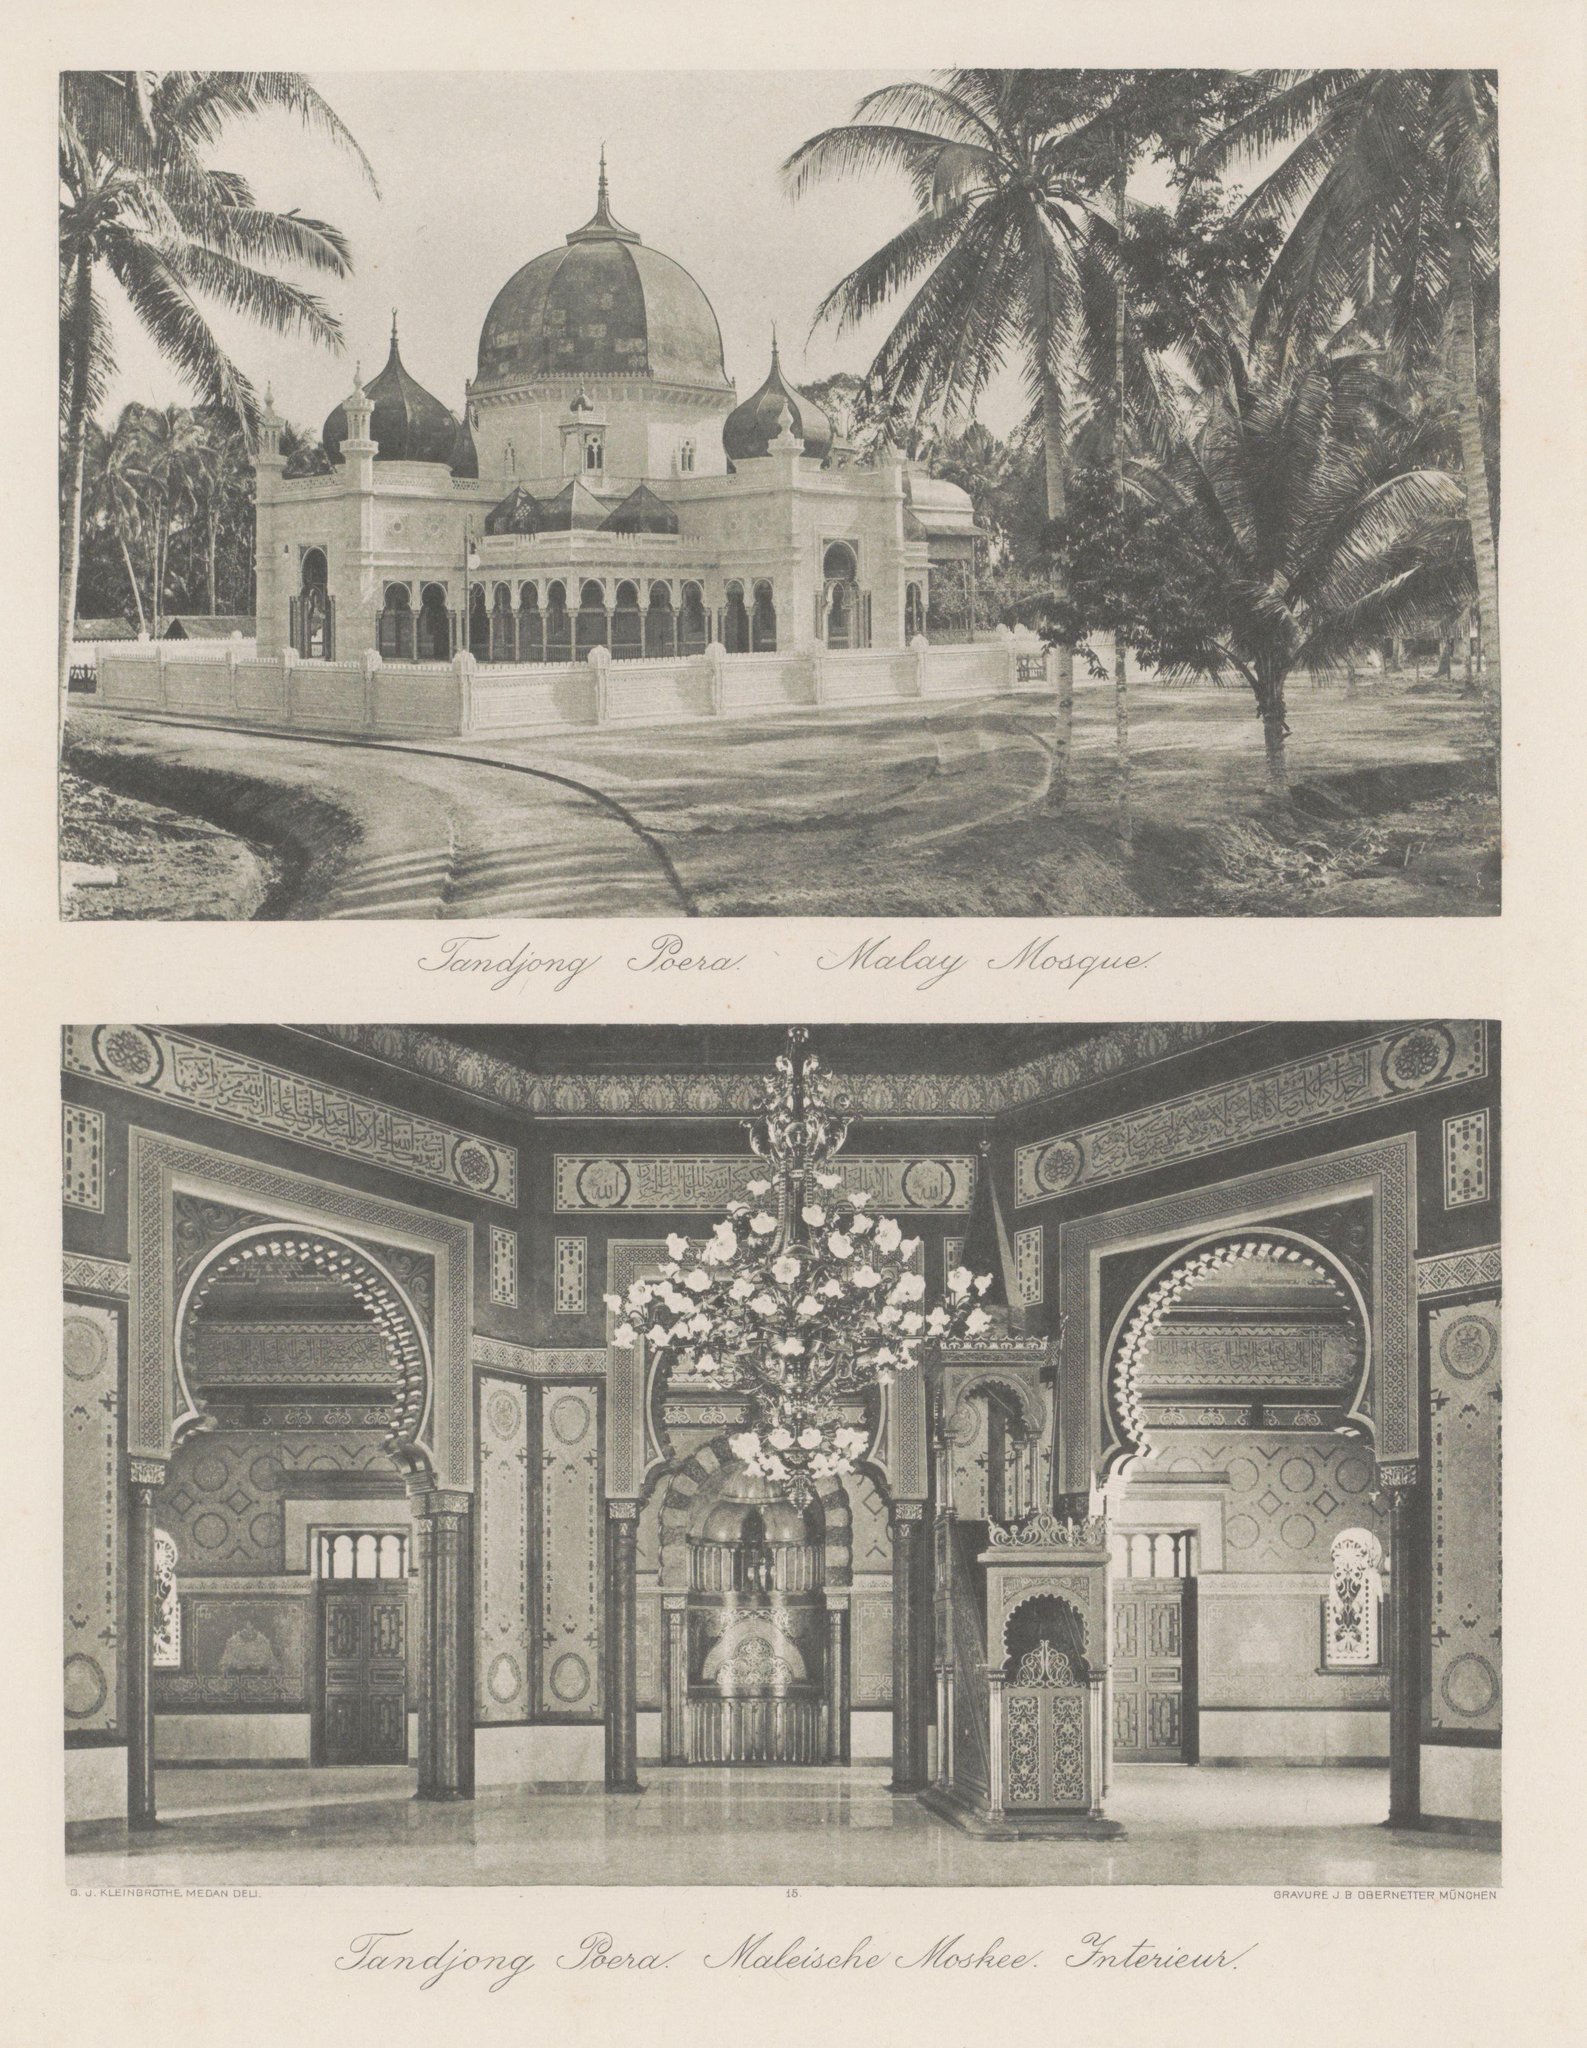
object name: photomechanical print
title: Exterieur (boven) en interieur (onder) van een Maleise moskee in Tanjungpura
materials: paper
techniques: photoaquatint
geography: munich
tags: temple, shrine ~ islam, mohammedanism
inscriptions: number: ‘15’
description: Onderdeel van Album met heliogravures van Sumatra's oostkust.